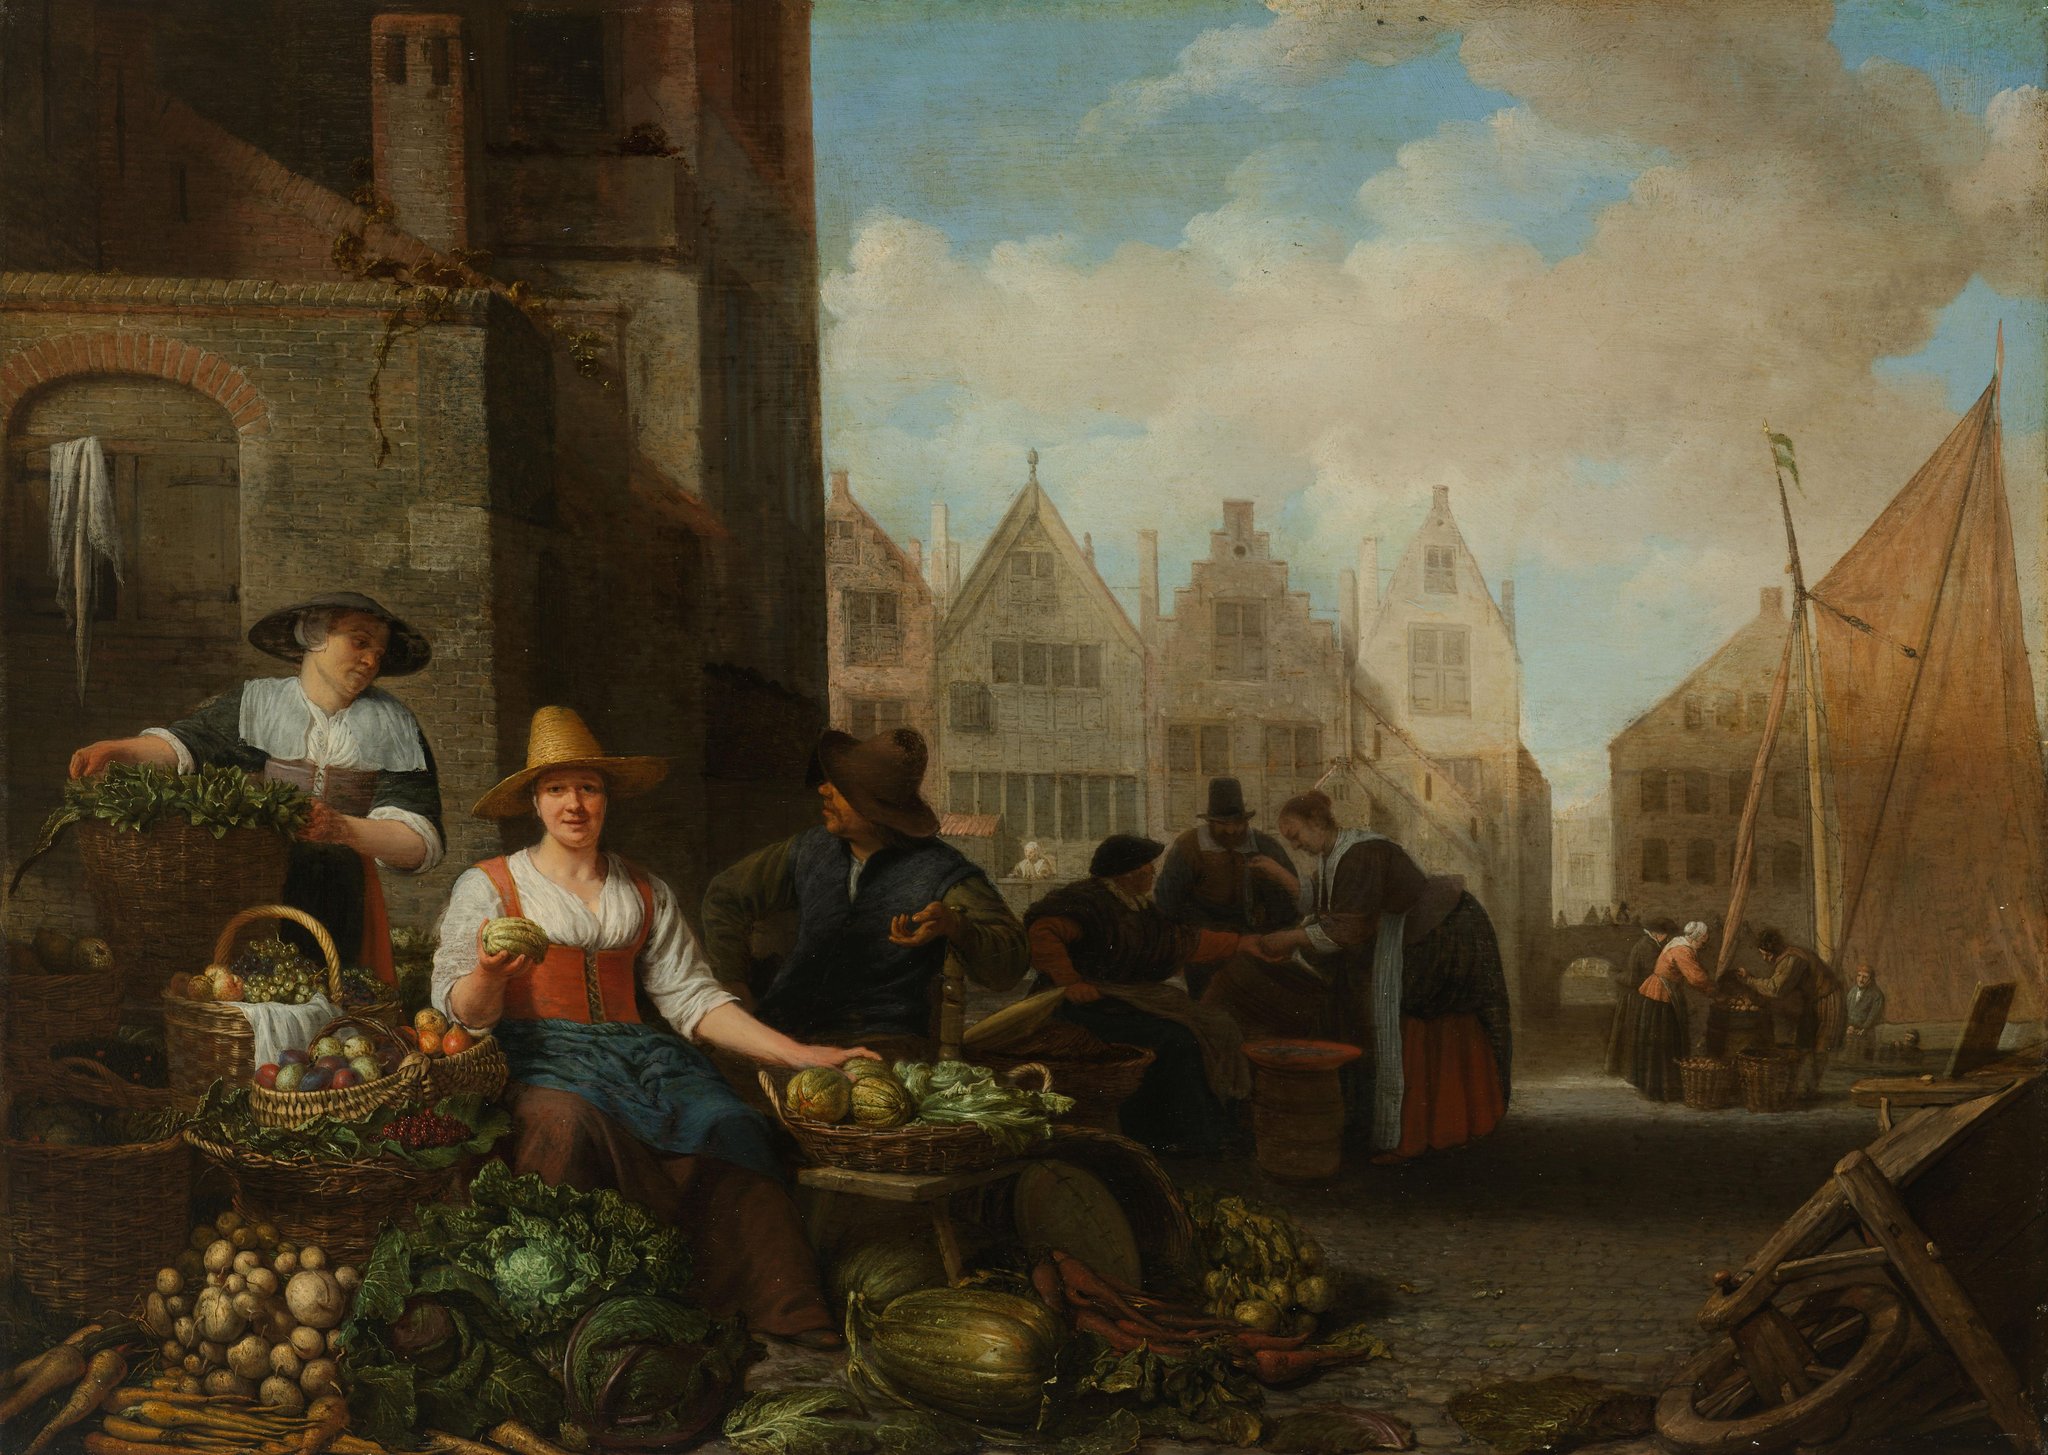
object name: painting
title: The Vegetable Market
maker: hendrick martensz. sorgh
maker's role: draughtsman, painter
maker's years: 1609-1670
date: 1662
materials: oil, panel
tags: square, place, circus, etc., vegetables, stall, booth (~ market)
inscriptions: signature and date: ‘1662 M. Sorgh’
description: De groentemarkt. Twee vrouwen en een man achter een kraam waar fruit en groente te koop wordt aangeboden. Een jonge vrouw met een hoed houdt een kalebas in haar uitgestrekte hand. Tot de waar behoren: kolen, wortels, rapen en knollen, artisjokken, kalebassen, bieten en pompoenen. Rechts ligt een kruiwagen, op de achtergrond marktbezoekers, het zeil van een schip en gevels van huizen aan een gracht.